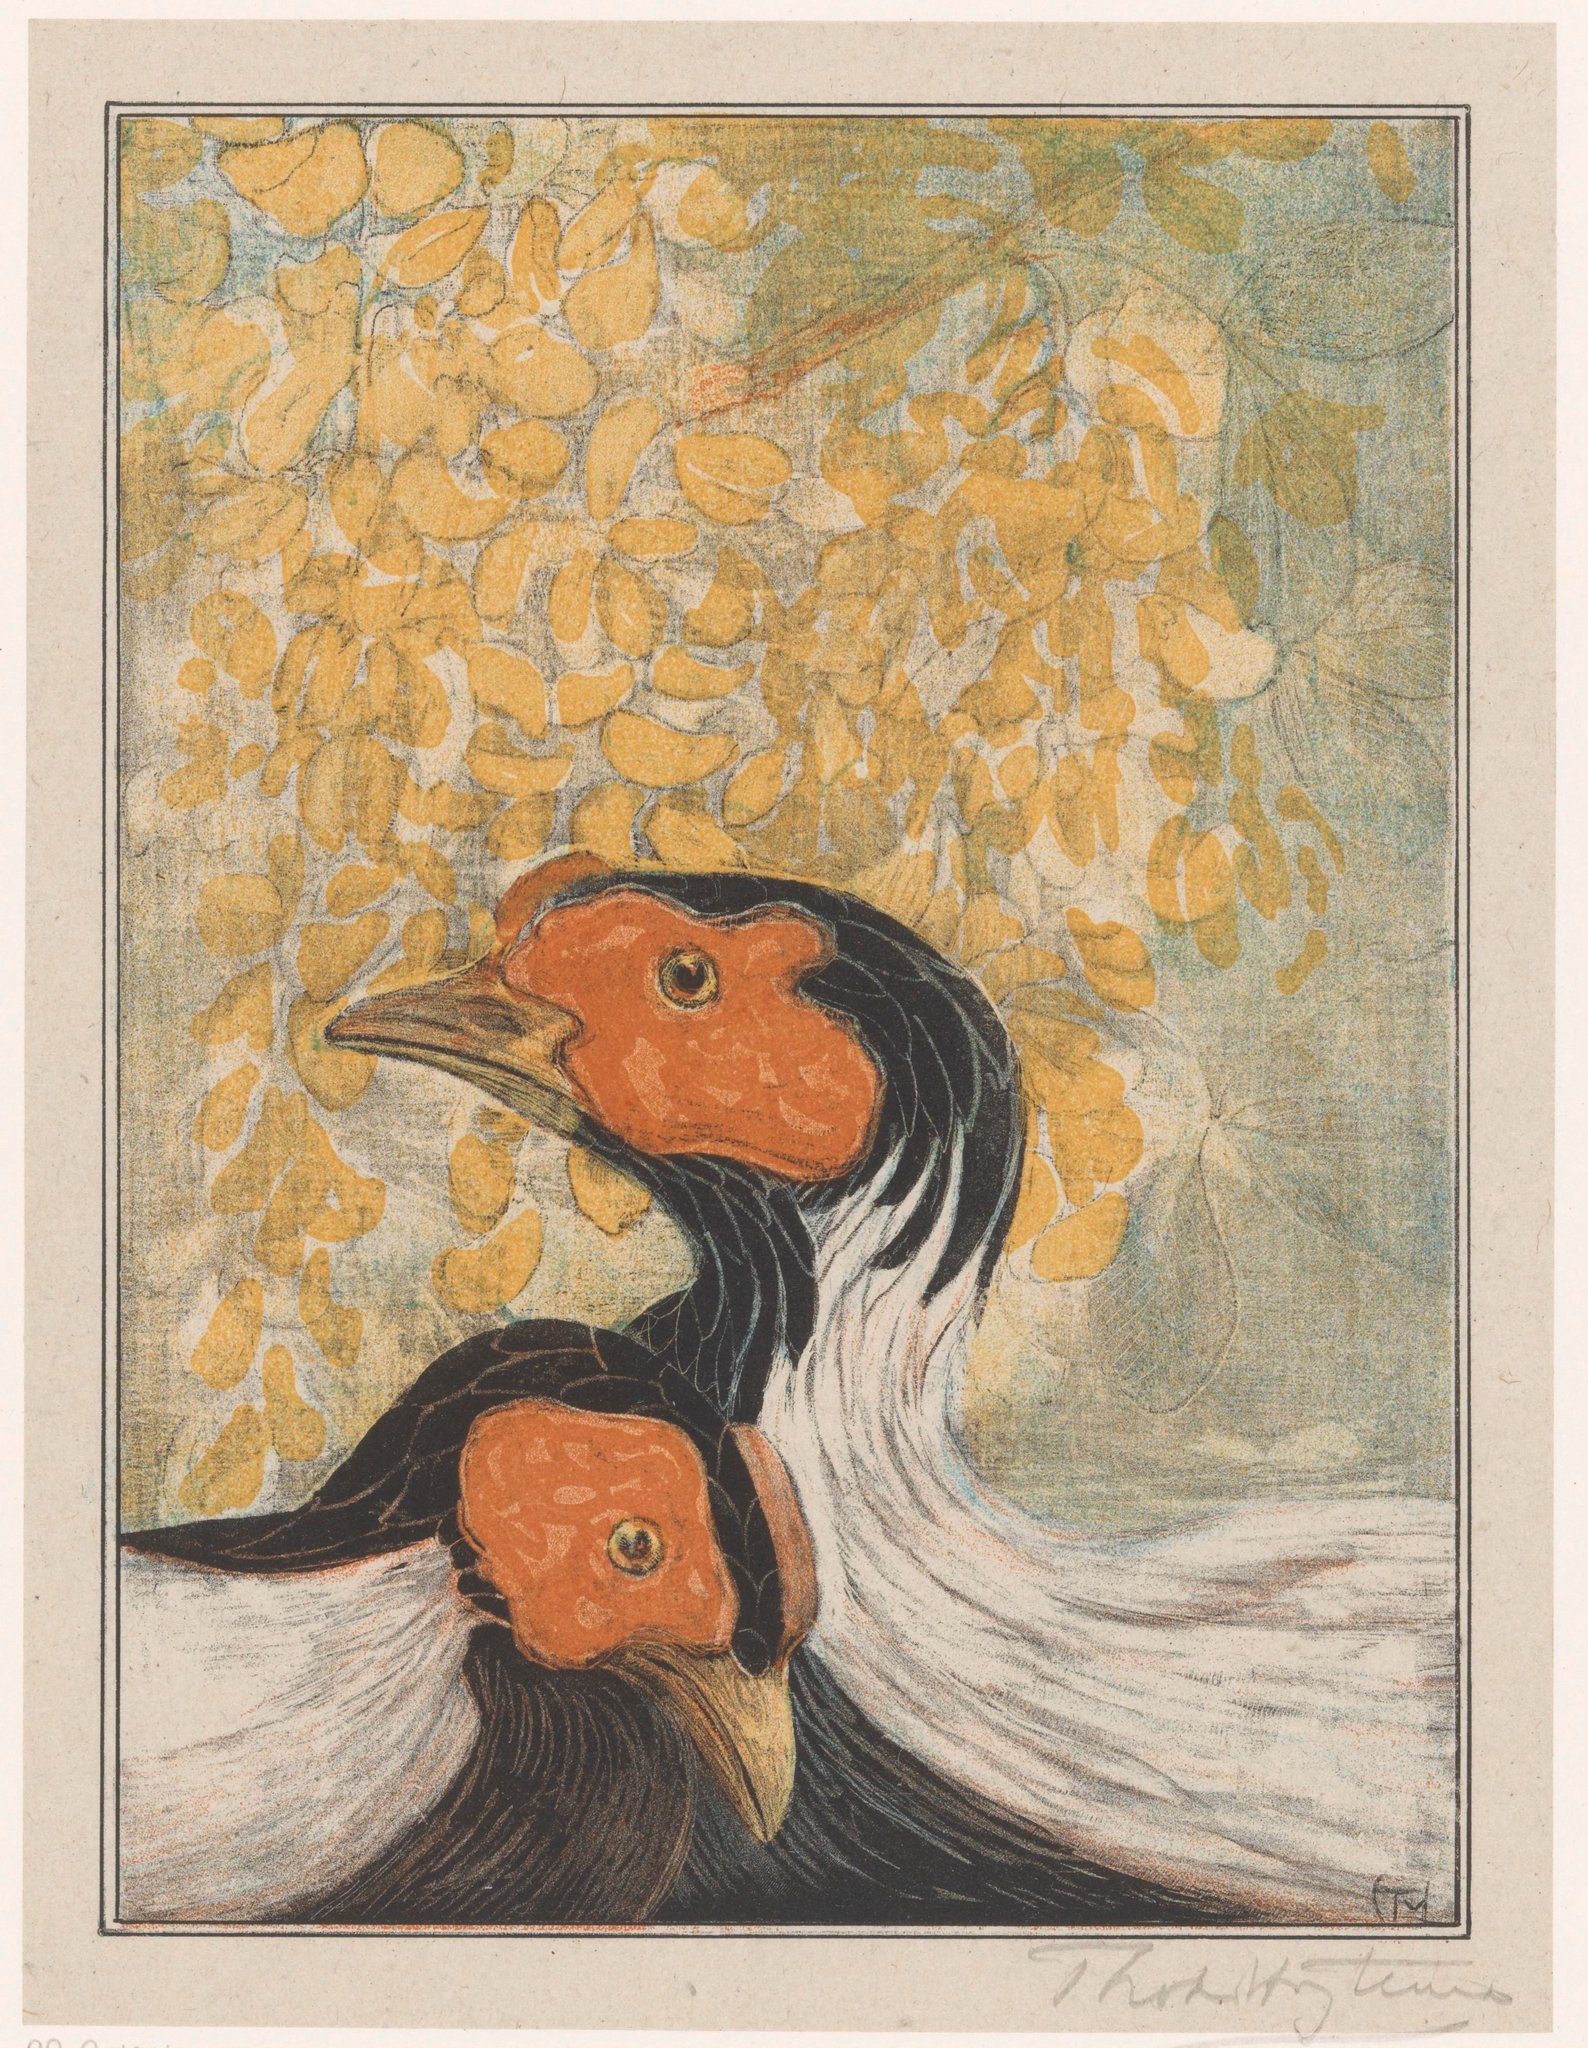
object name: print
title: Twee zilverfazanten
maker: theo van hoytema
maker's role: draughtsman, painter, print maker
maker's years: 1863-1917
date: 1878-1905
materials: paper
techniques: lithograph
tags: walker and runner birds: pheasant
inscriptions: collector's mark: Lugt 2233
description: Prent is een proefdruk voor kalenderblad mei 1905.